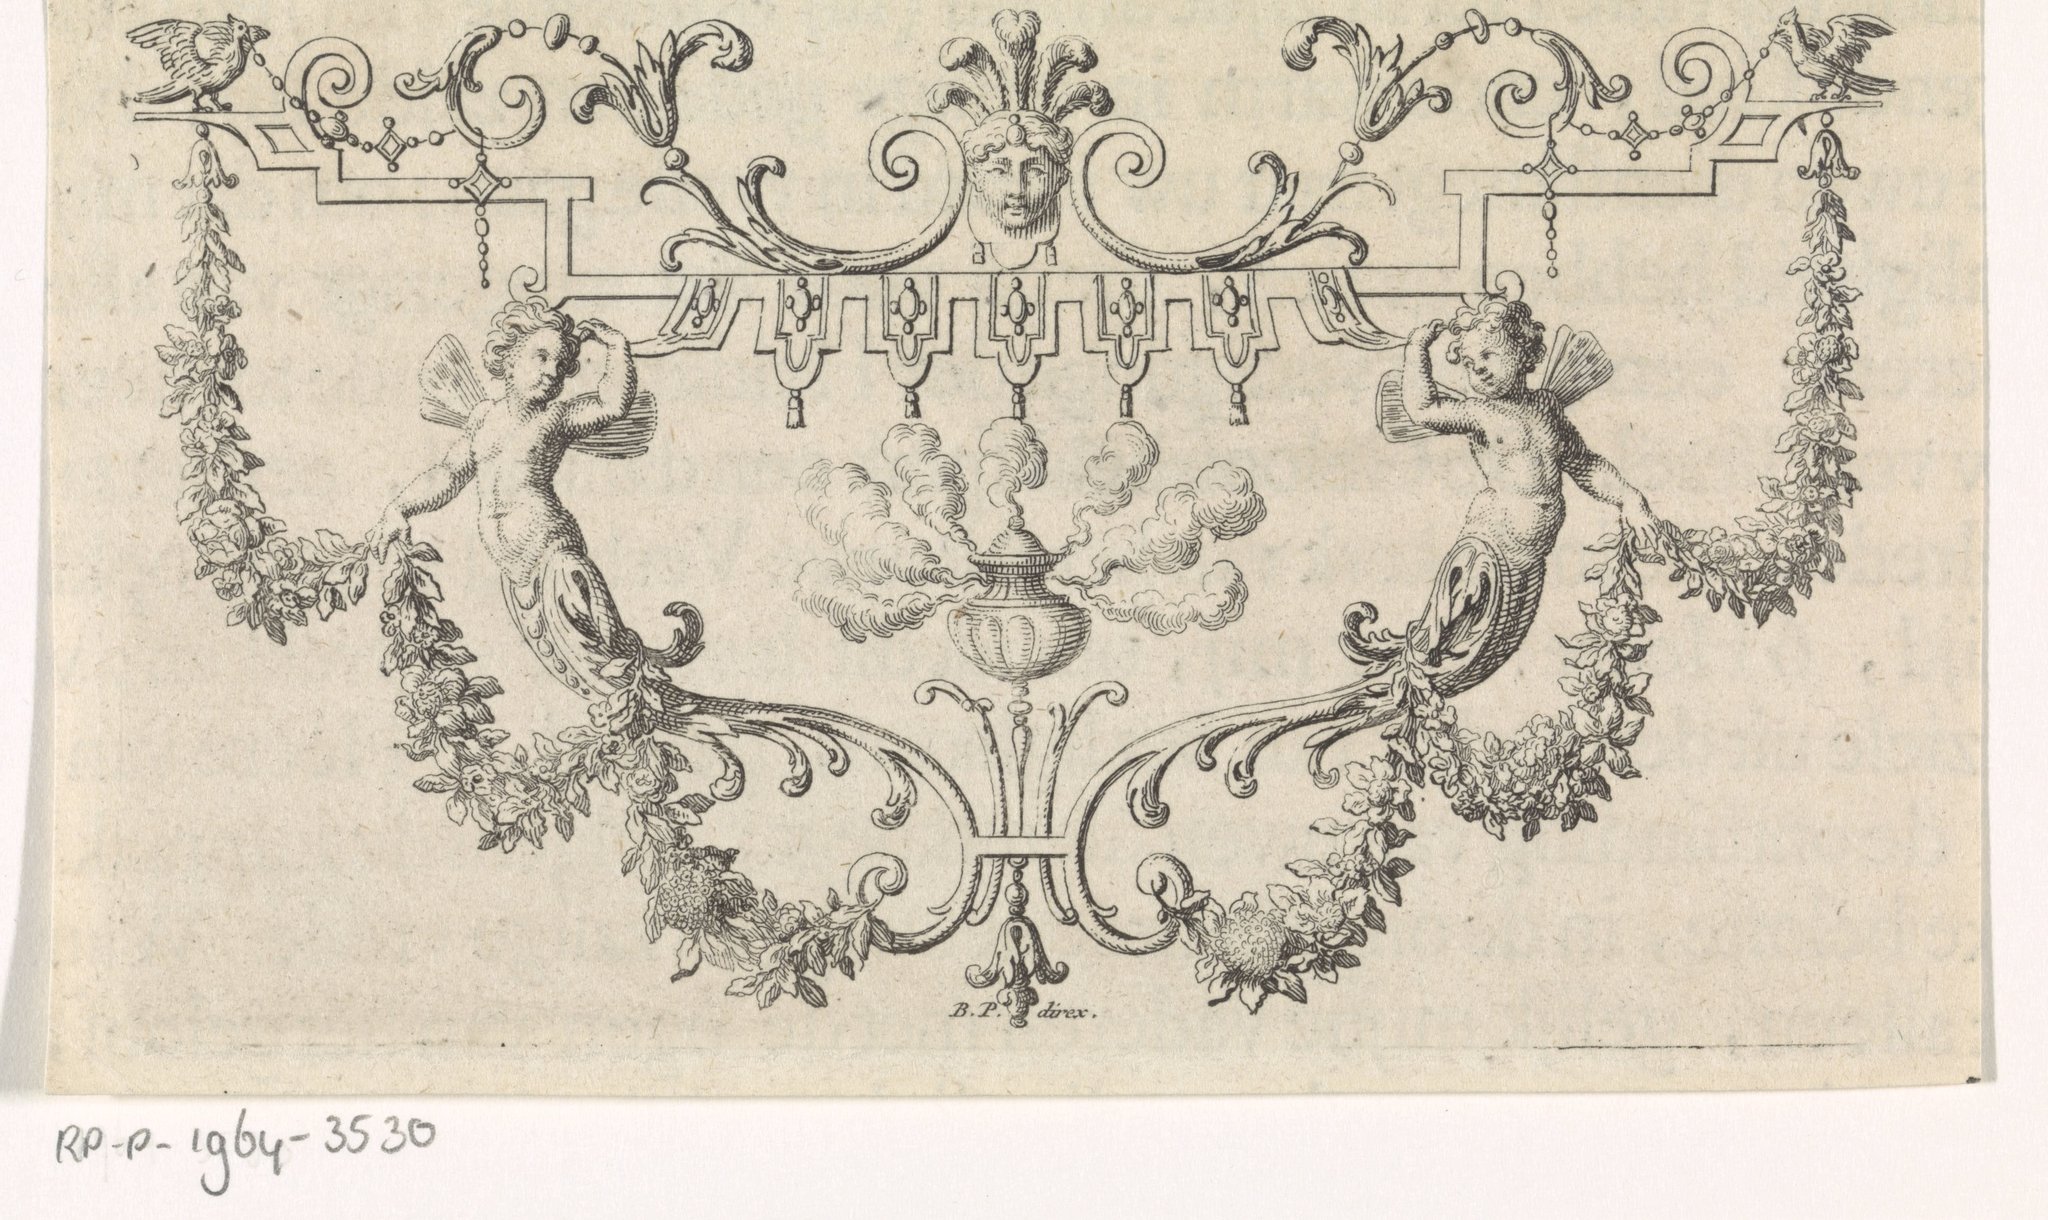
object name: book illustration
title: Wierookvat in omlijsting met guirlandes en hybride putti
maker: bernard picart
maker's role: draughtsman, print maker, publisher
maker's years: 1673-1733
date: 1683-1733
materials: paper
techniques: engraving, etching, letterpress printing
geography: amsterdam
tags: ornament ~ hybrid beings; human and animal forms mixed, censer, mask, mascaron ~ ornament, ornament ~ festoon, garland, foliage, tendrils, branches ~ ornament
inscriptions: collector's mark: Lugt 2228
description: Prent oorspronkelijk bedoeld voor: Figures de la Bible. Amsterdam, Bernard Picart, 1720. Prent ook gebruikt in: Taferelen der voornaamste geschiedenissen van het Oude en Nieuwe Testament (...) door de vermaarde kunstenaars Hoet, Houbraken, en Picart getekent (...) en met beschrijvingen uitgebreid. Den Haag: Pieter de Hondt, 1728. Prent kan mogelijk ook zijn gebruikt in andere bijbels.